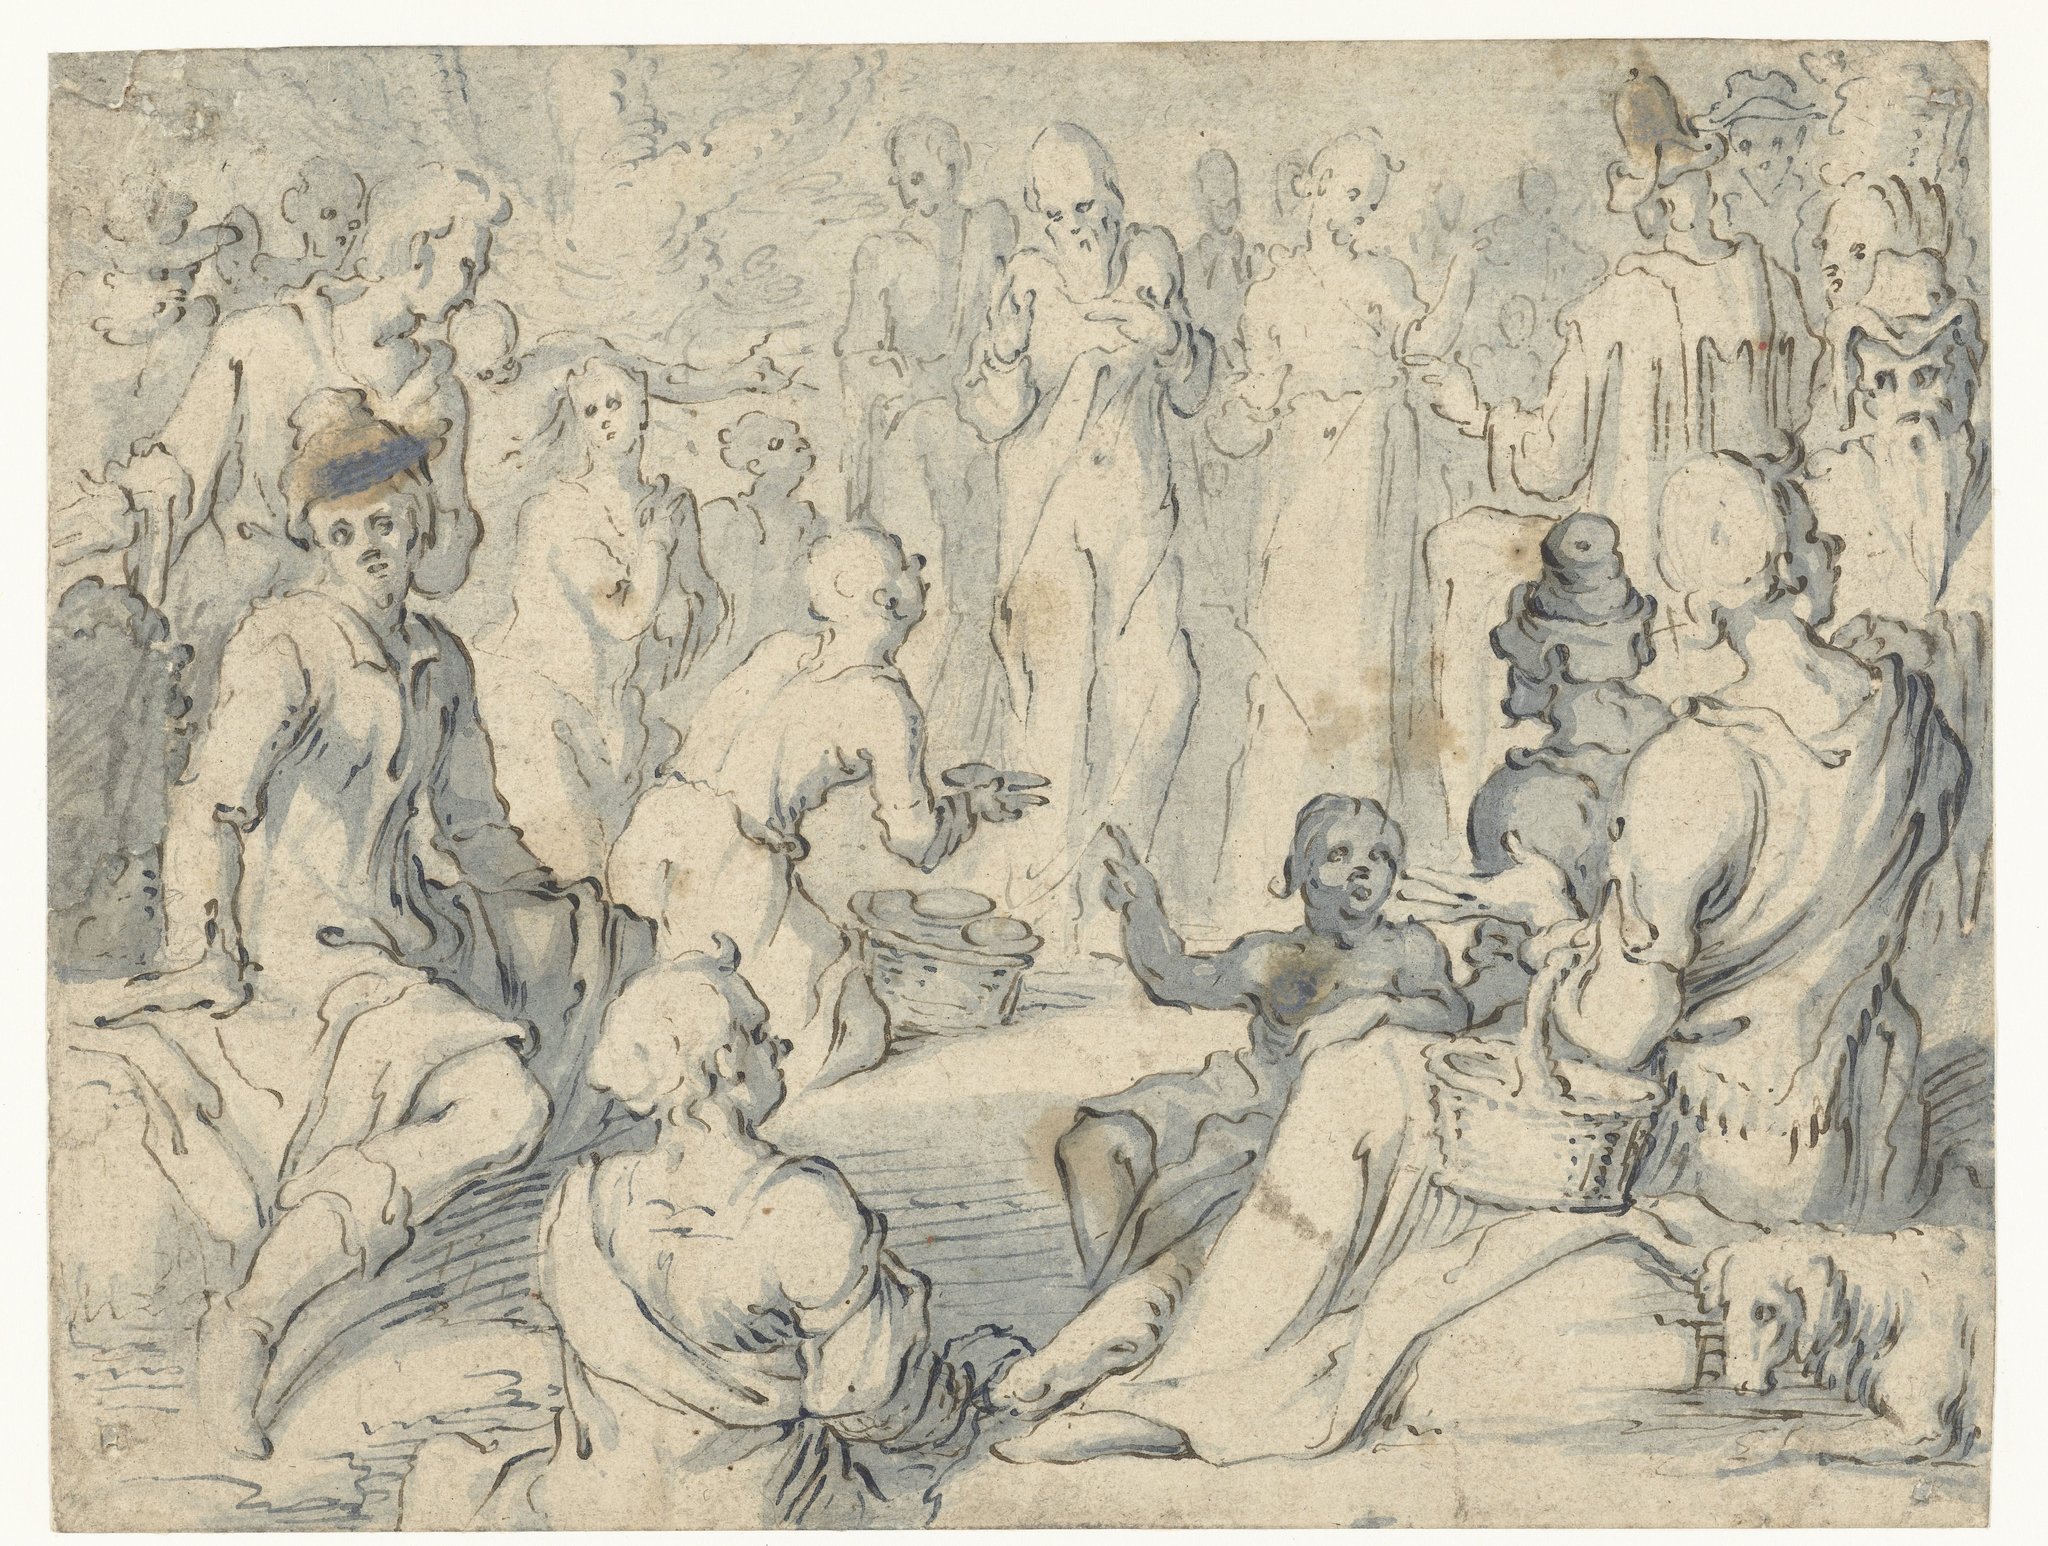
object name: drawing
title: Wonderbare spijziging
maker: Anonymous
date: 1575-1624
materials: ink, paper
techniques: brush, pen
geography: low countries